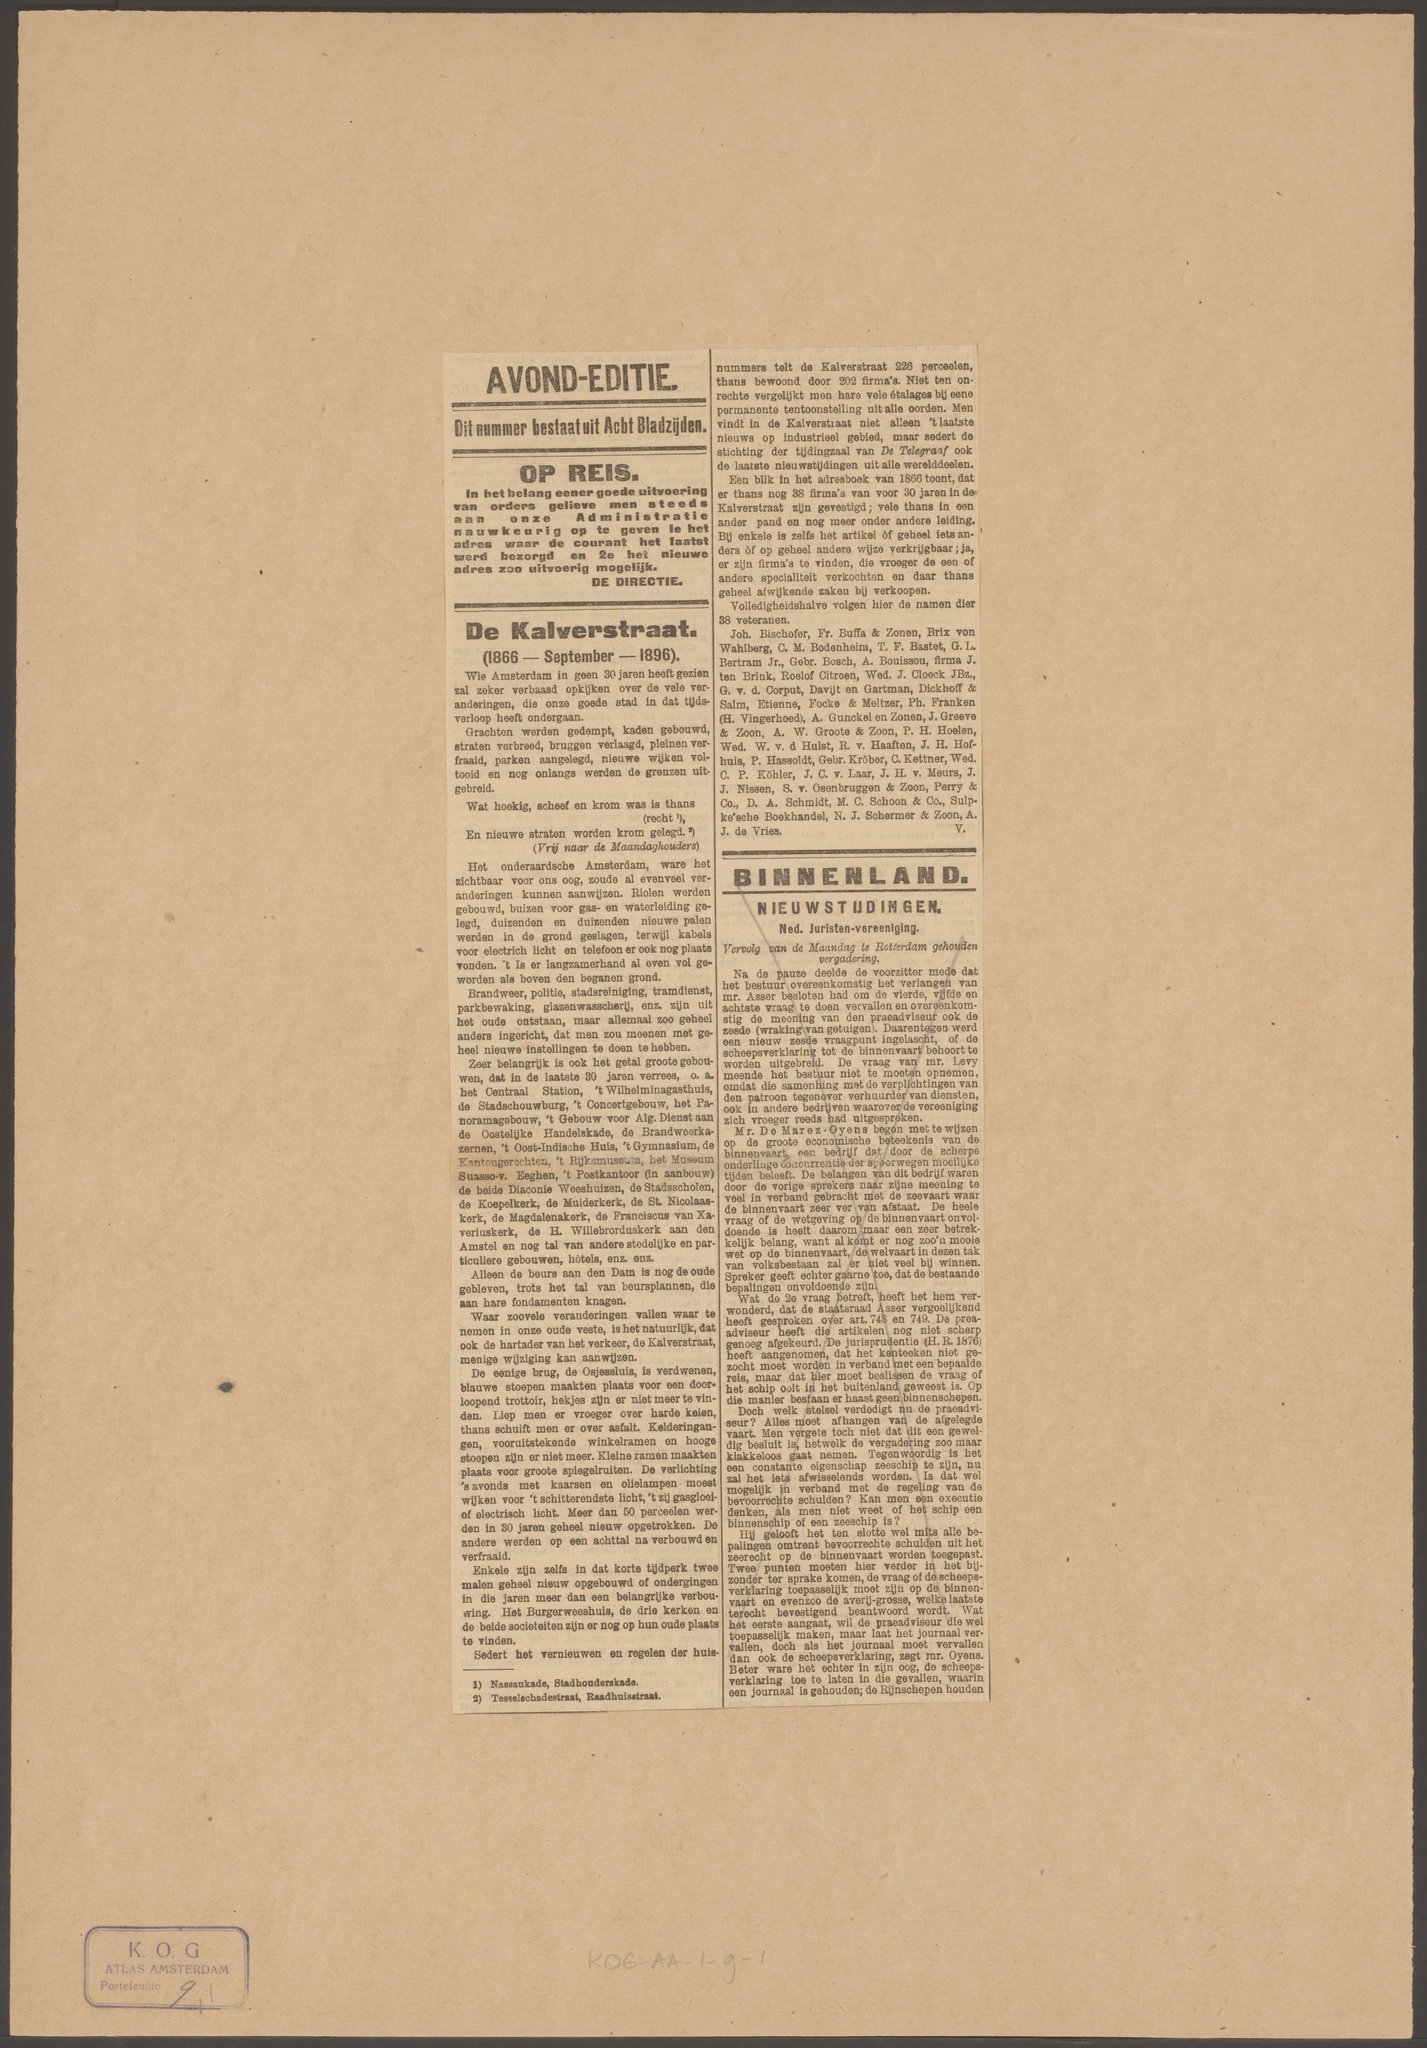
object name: text sheet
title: Tekst over de veranderingen in de Kalverstraat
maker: Anonymous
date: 1896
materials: paper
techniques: letterpress printing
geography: amsterdam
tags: street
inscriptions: collector's mark: ‘9, 1’ Lugt 1641b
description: Onderwerpsrubriek binnen de Atlas Amsterdam: Kadijksplein, Karthuizerkerkhof, Kattegat, Kattenburg, Kapelsteeg O.Z., Enge Kerksteeg, Kerkstraat, Kinkerstraat, Kolk O.Z., Koningsplein, Kromboomsloot [Krom Boomssloot], Kostverlorenkade, Kwakersdwarspad, Kalverstraat, Keizersgracht (v.d. Brouwersgracht – Amstel), Klerensloot (Gedempte), Klimopstraat, Kloveniersburgwal, Kraansluis.